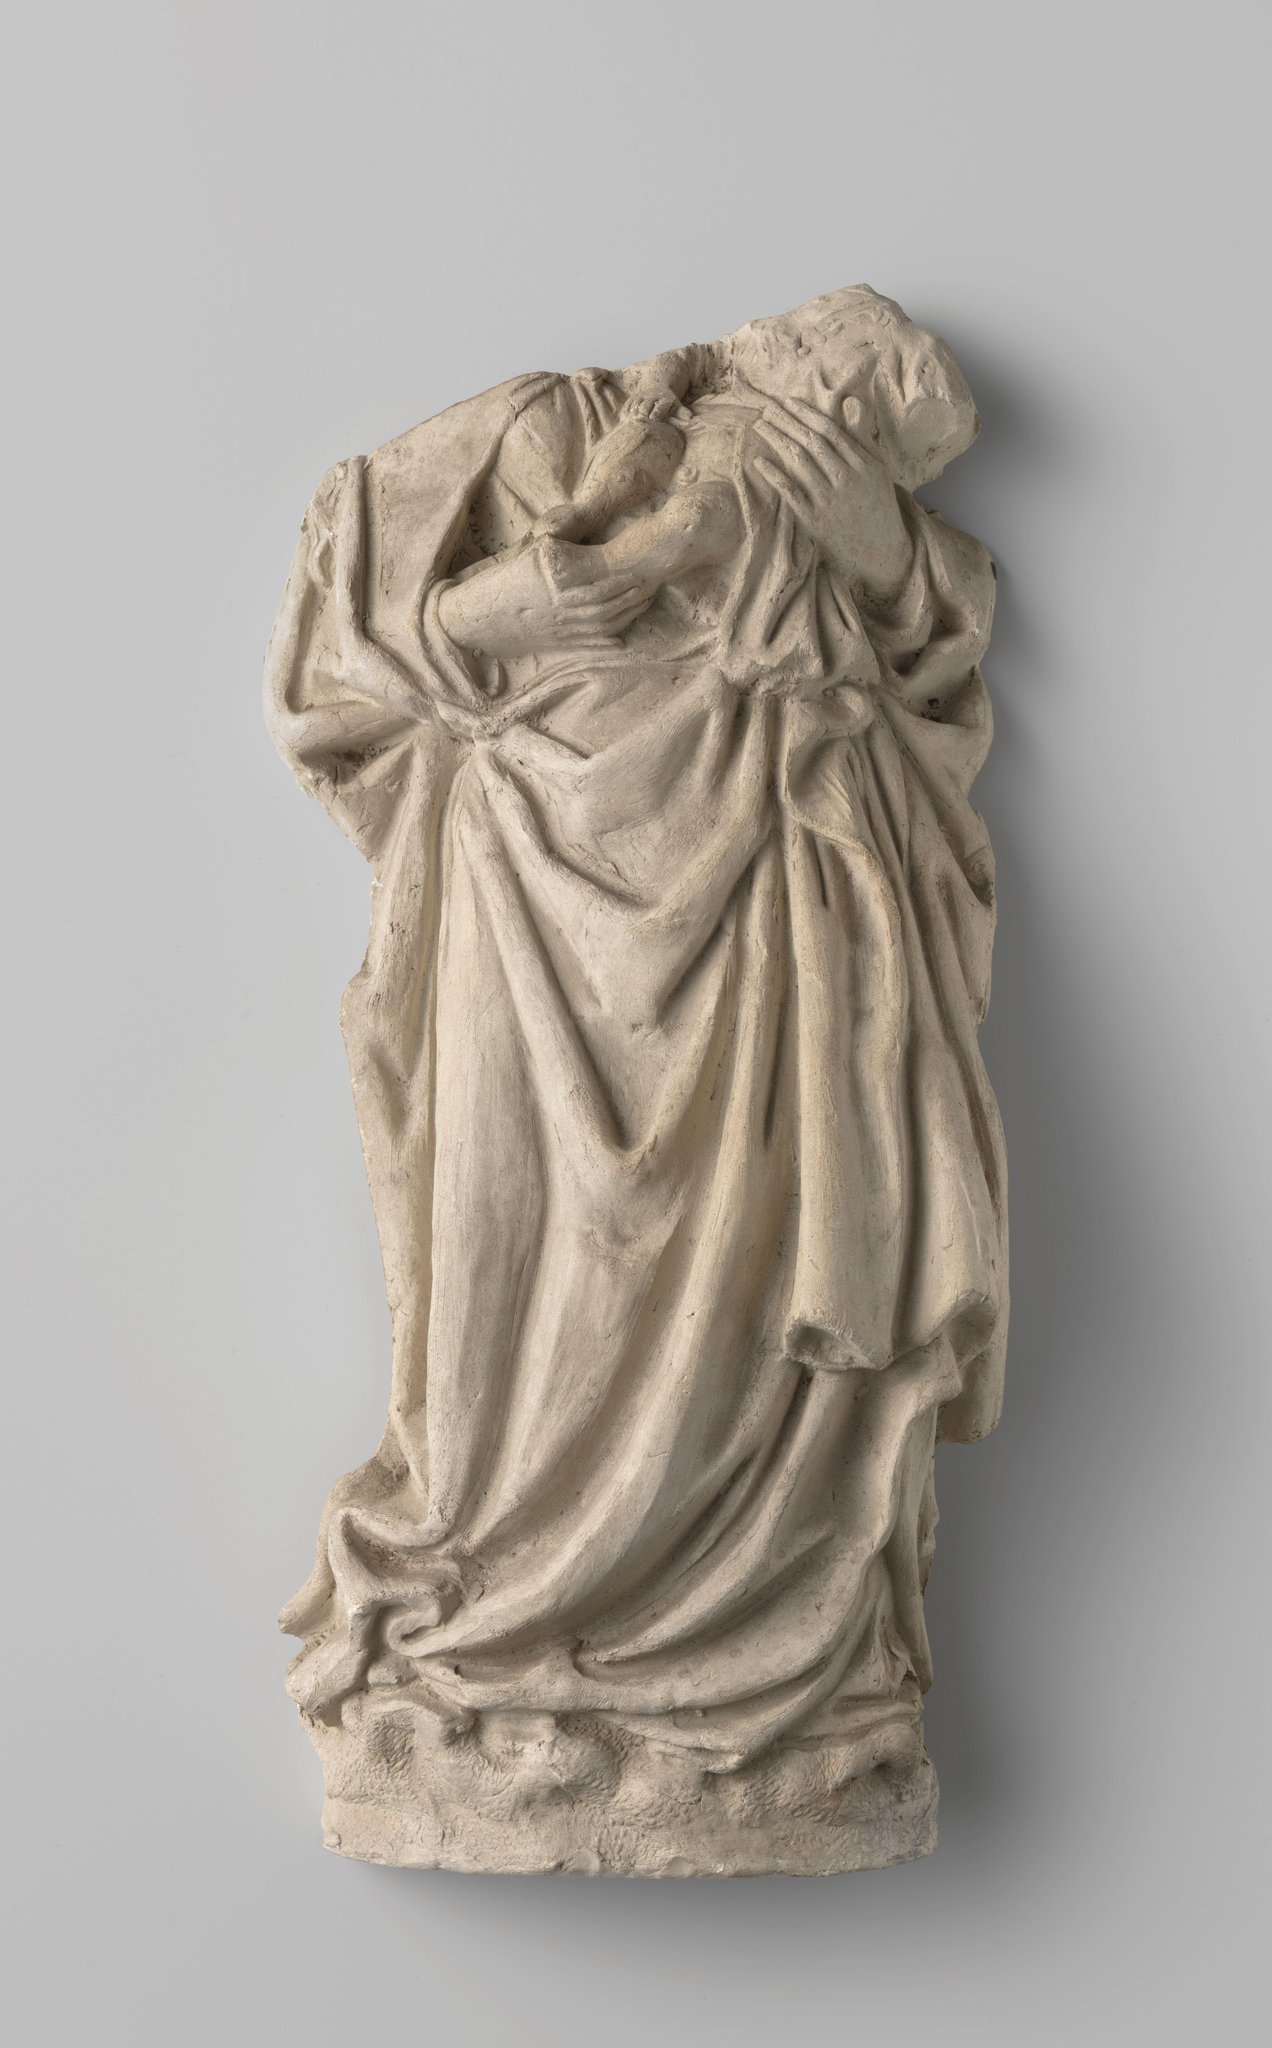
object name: figure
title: Beeld van de Heilige Maagd met het Christuskind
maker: Anonymous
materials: gypsum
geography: utrecht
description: Beeld van de Heilige Maagd met het Christuskind. Alleen de voorzijde. Gipsafgietsel. De vorm bevindt zich in de gemeenteverzameling in Utrecht.